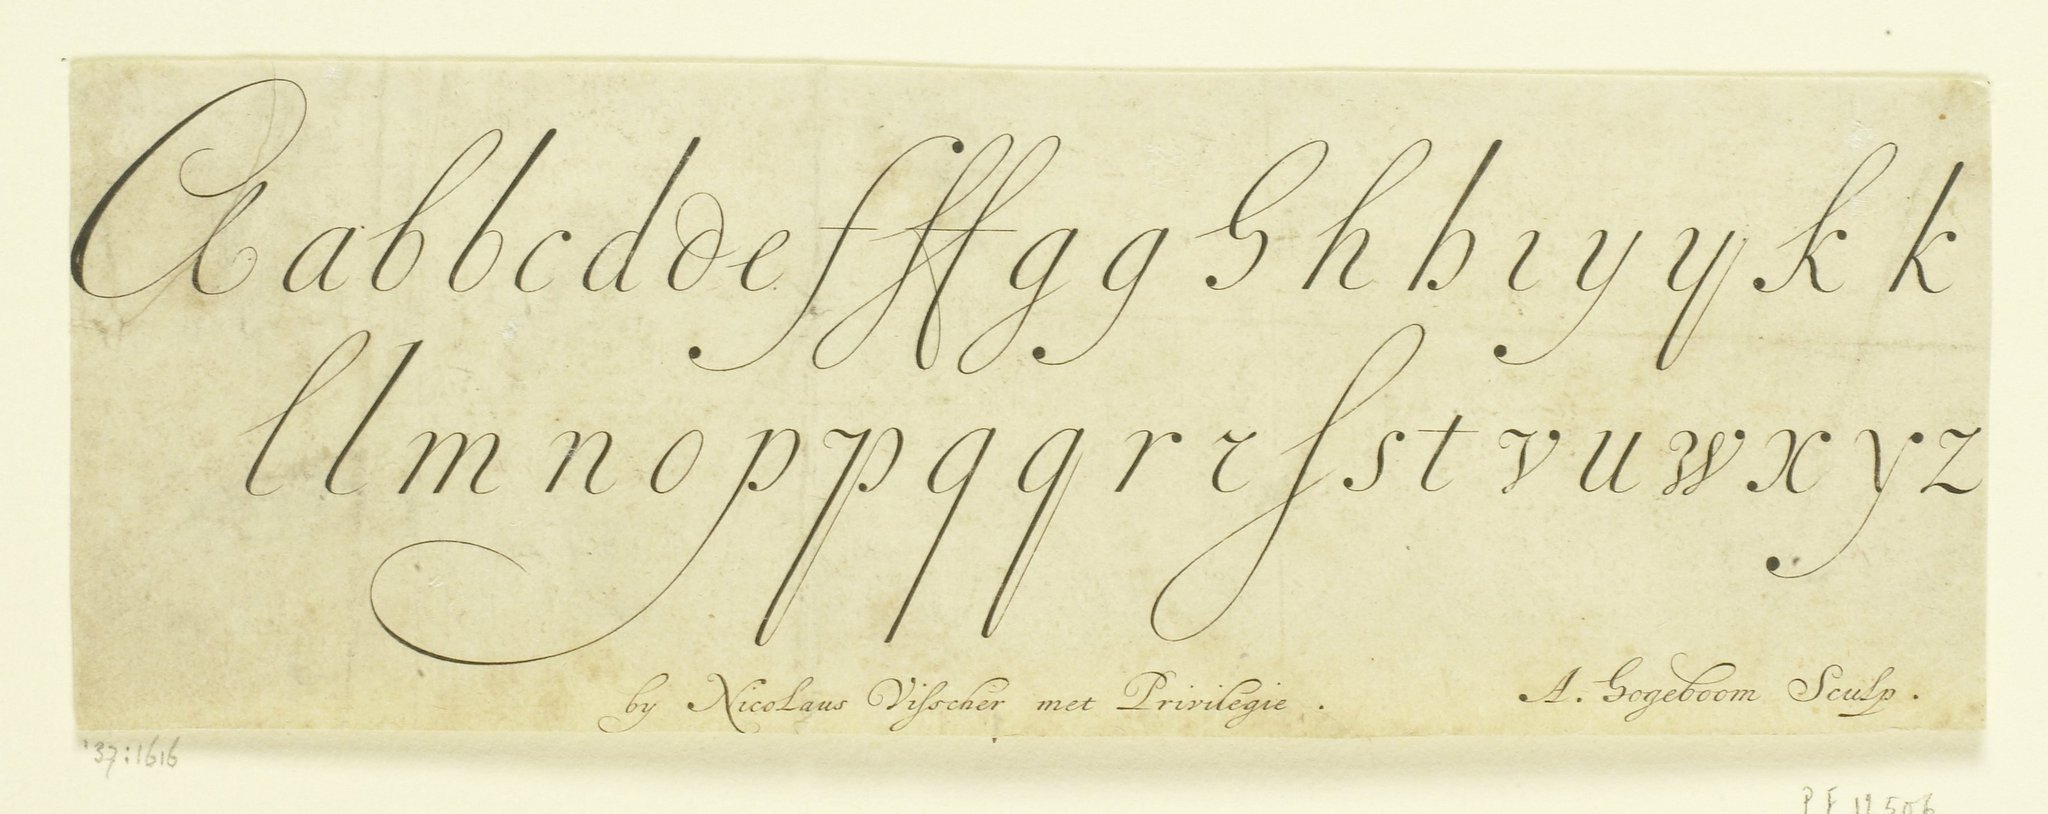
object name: ornament print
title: Gekalligrafeerd alfabet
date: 1680-1701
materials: paper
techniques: engraving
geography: amsterdam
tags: calligraphy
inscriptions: collector's mark: Lugt 2228